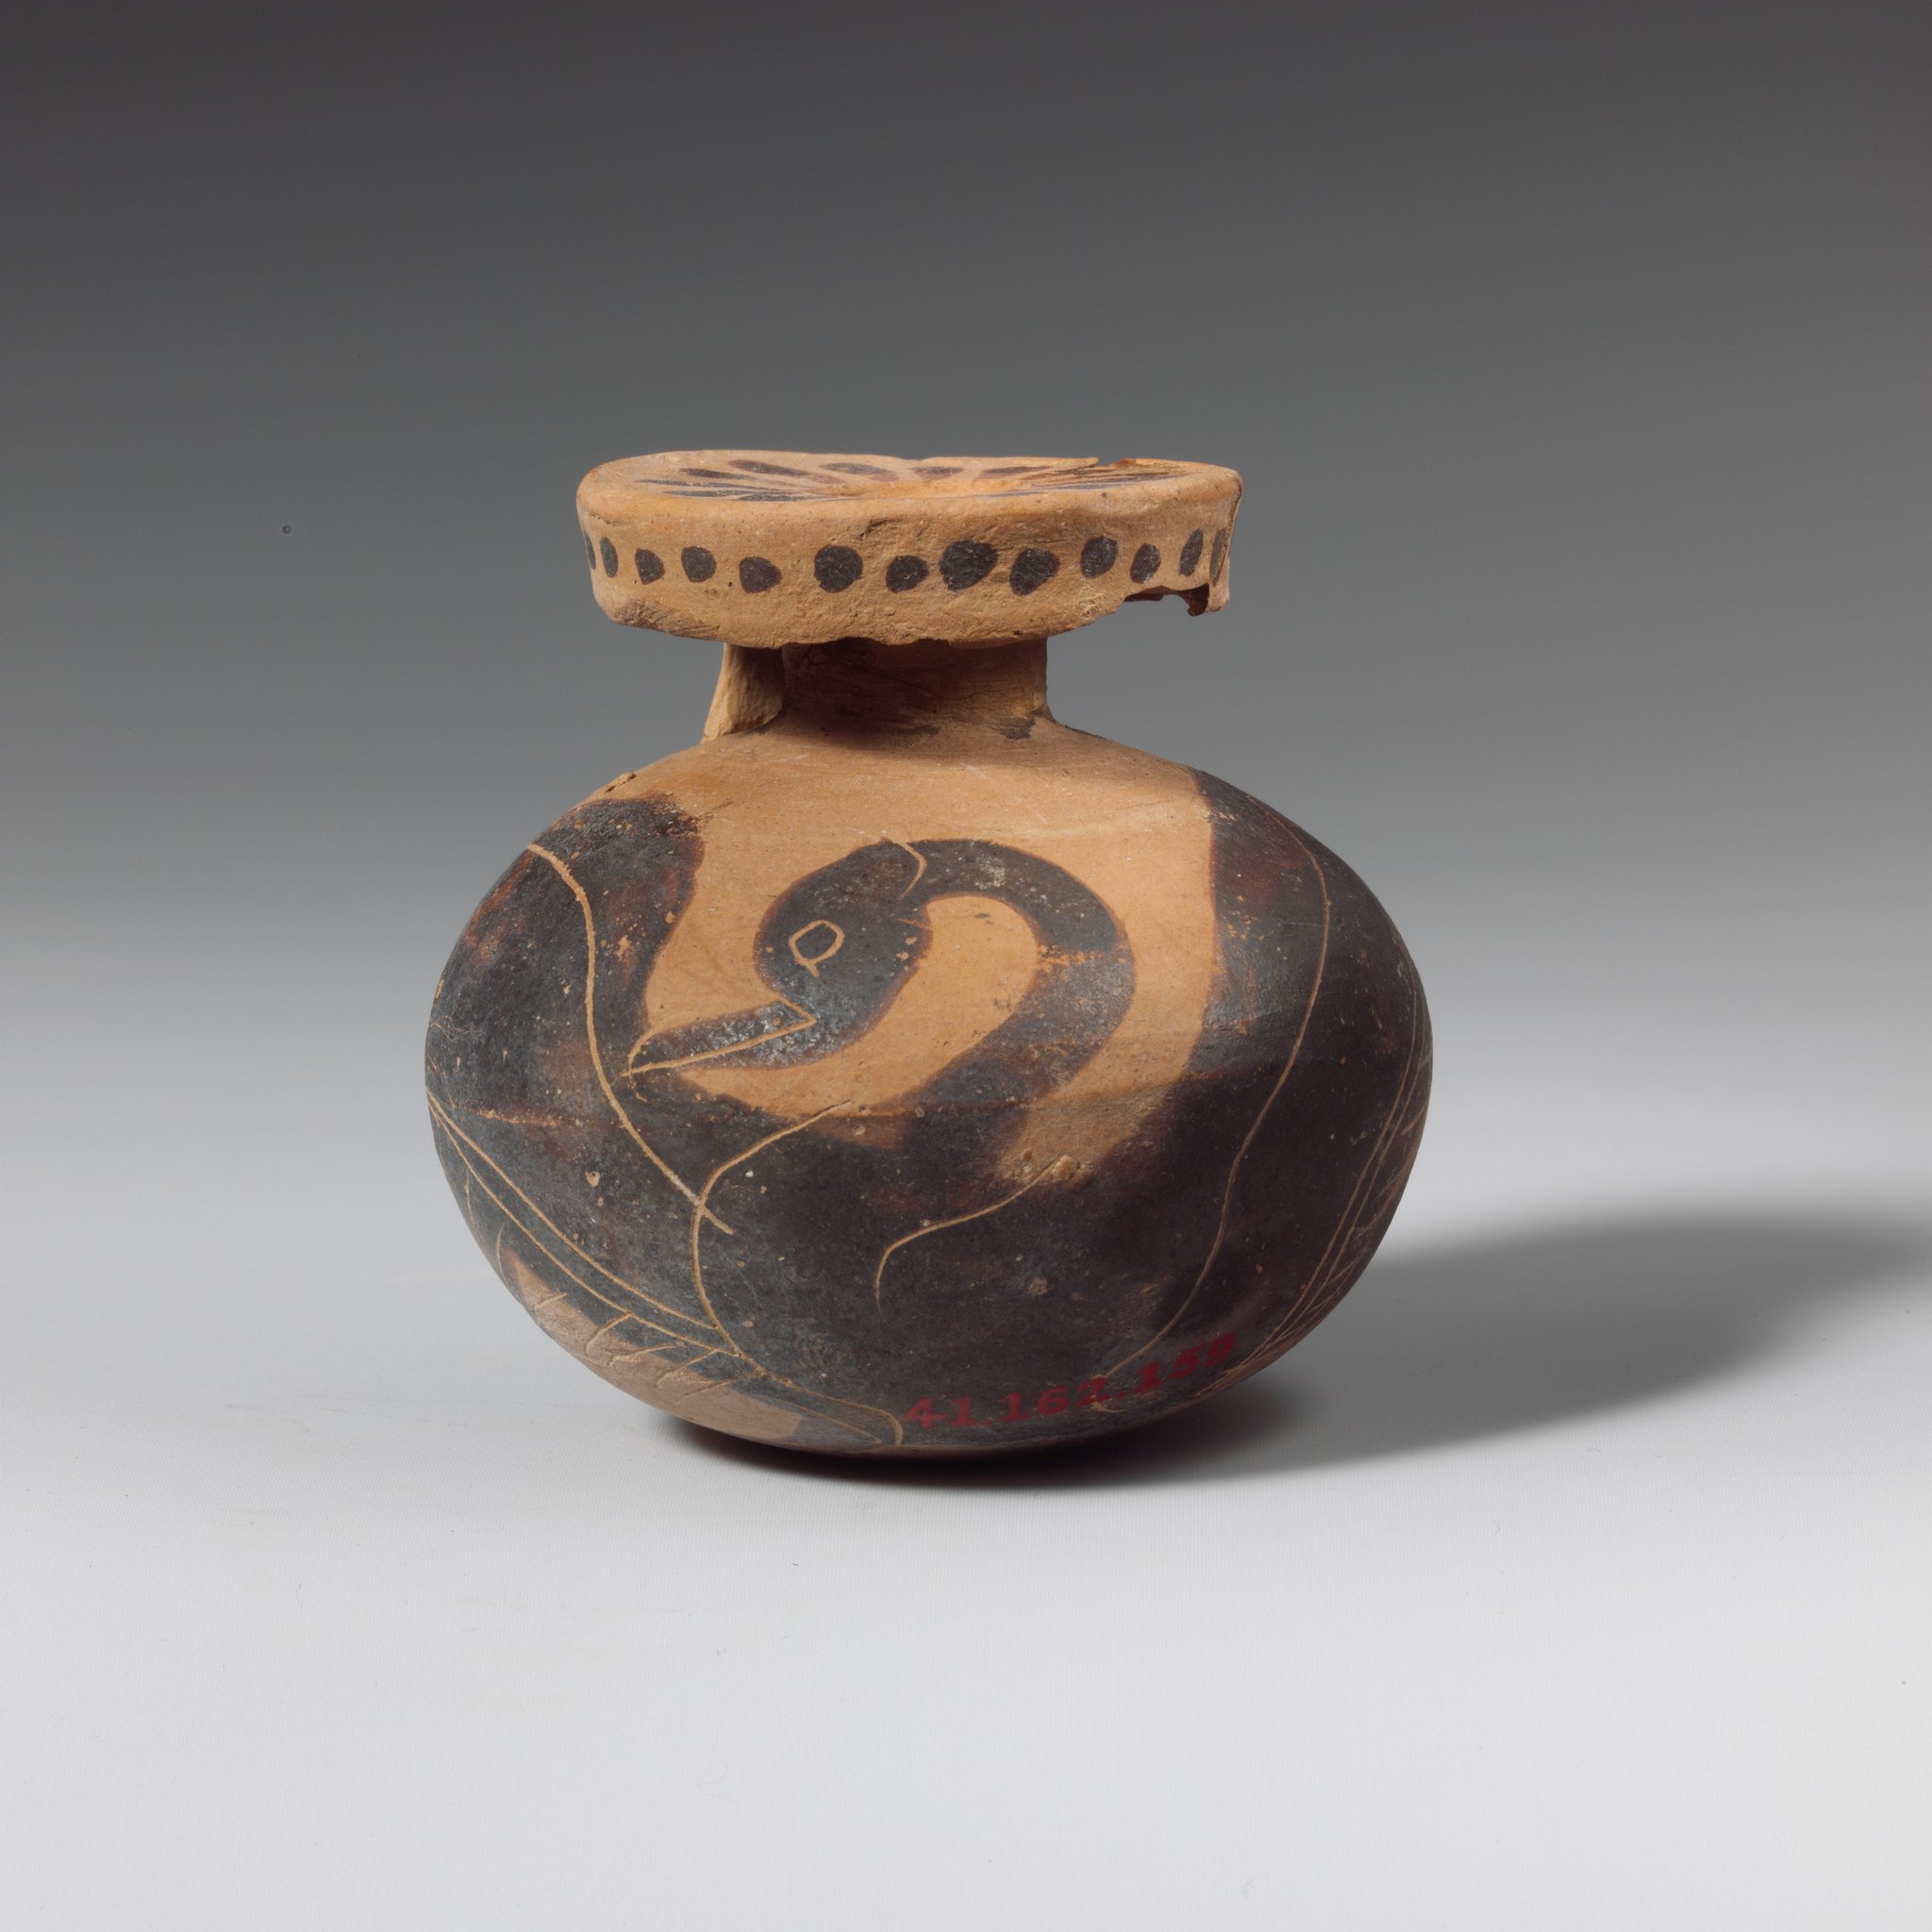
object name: aryballos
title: Terracotta aryballos (oil flask)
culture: greek, corinthian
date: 575-550 BCE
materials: terracotta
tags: swans